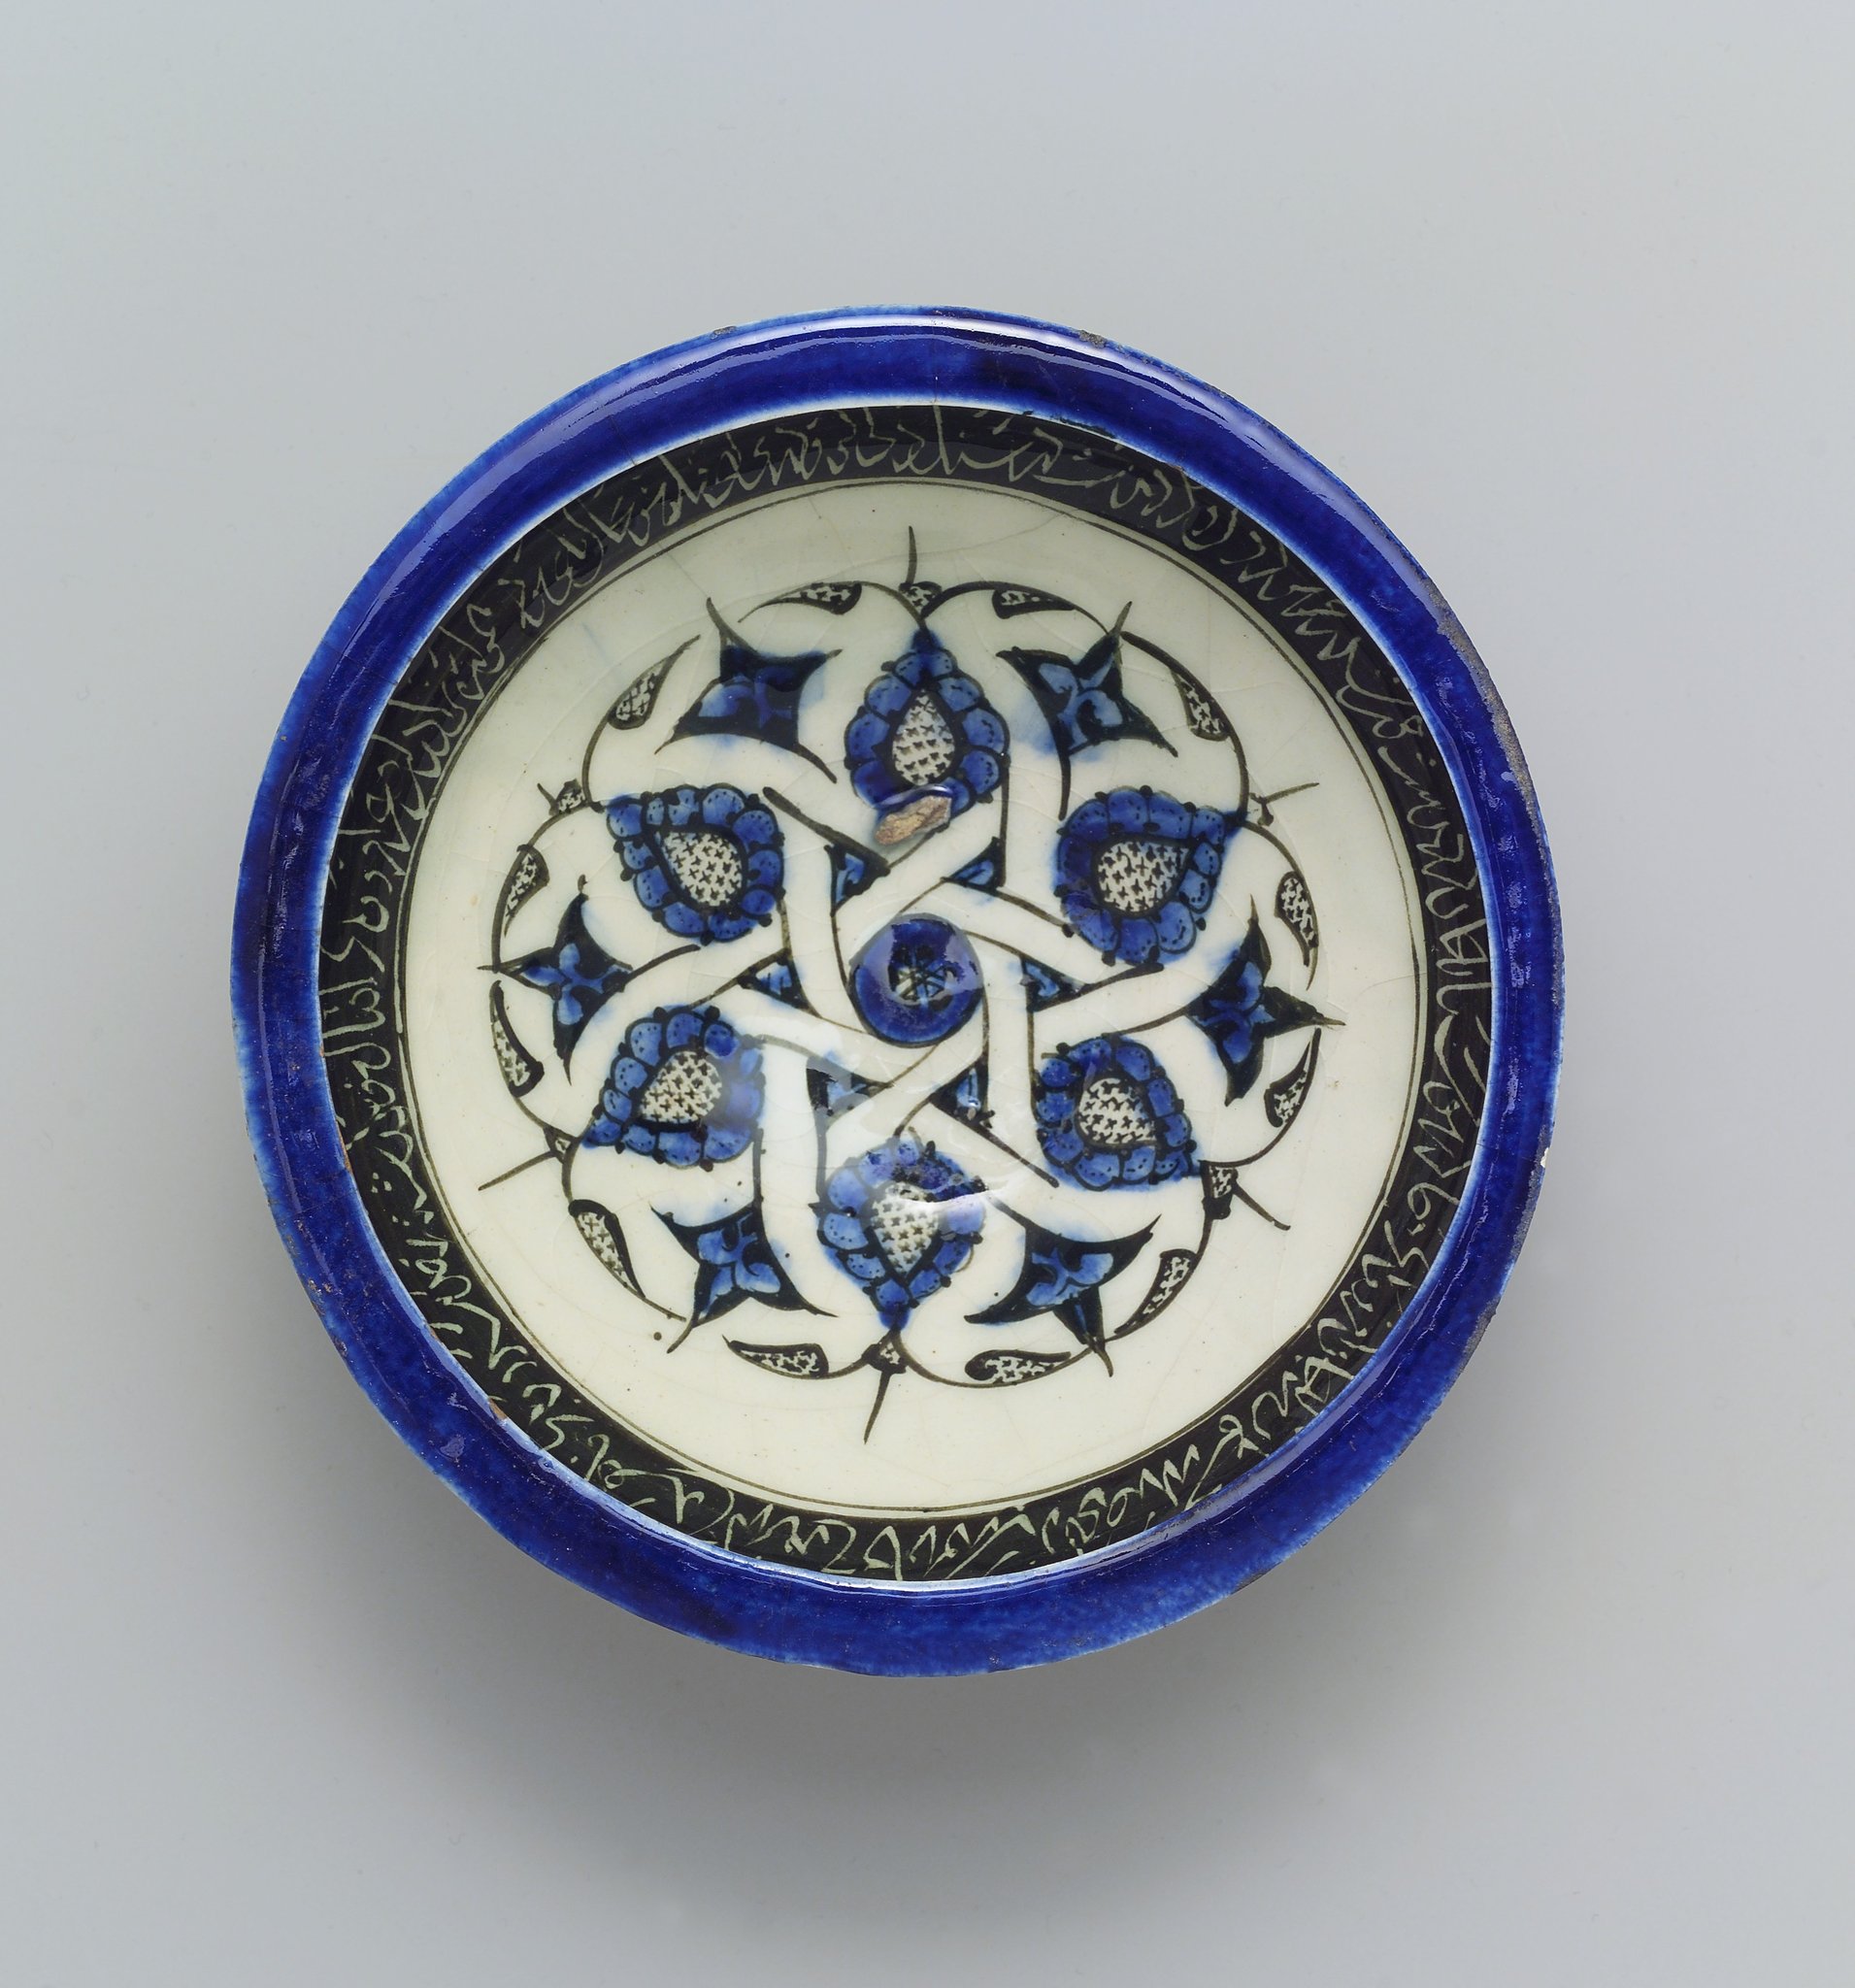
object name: bowl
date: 1201-1300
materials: glaze, stonepaste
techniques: painting, polychrome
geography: iran